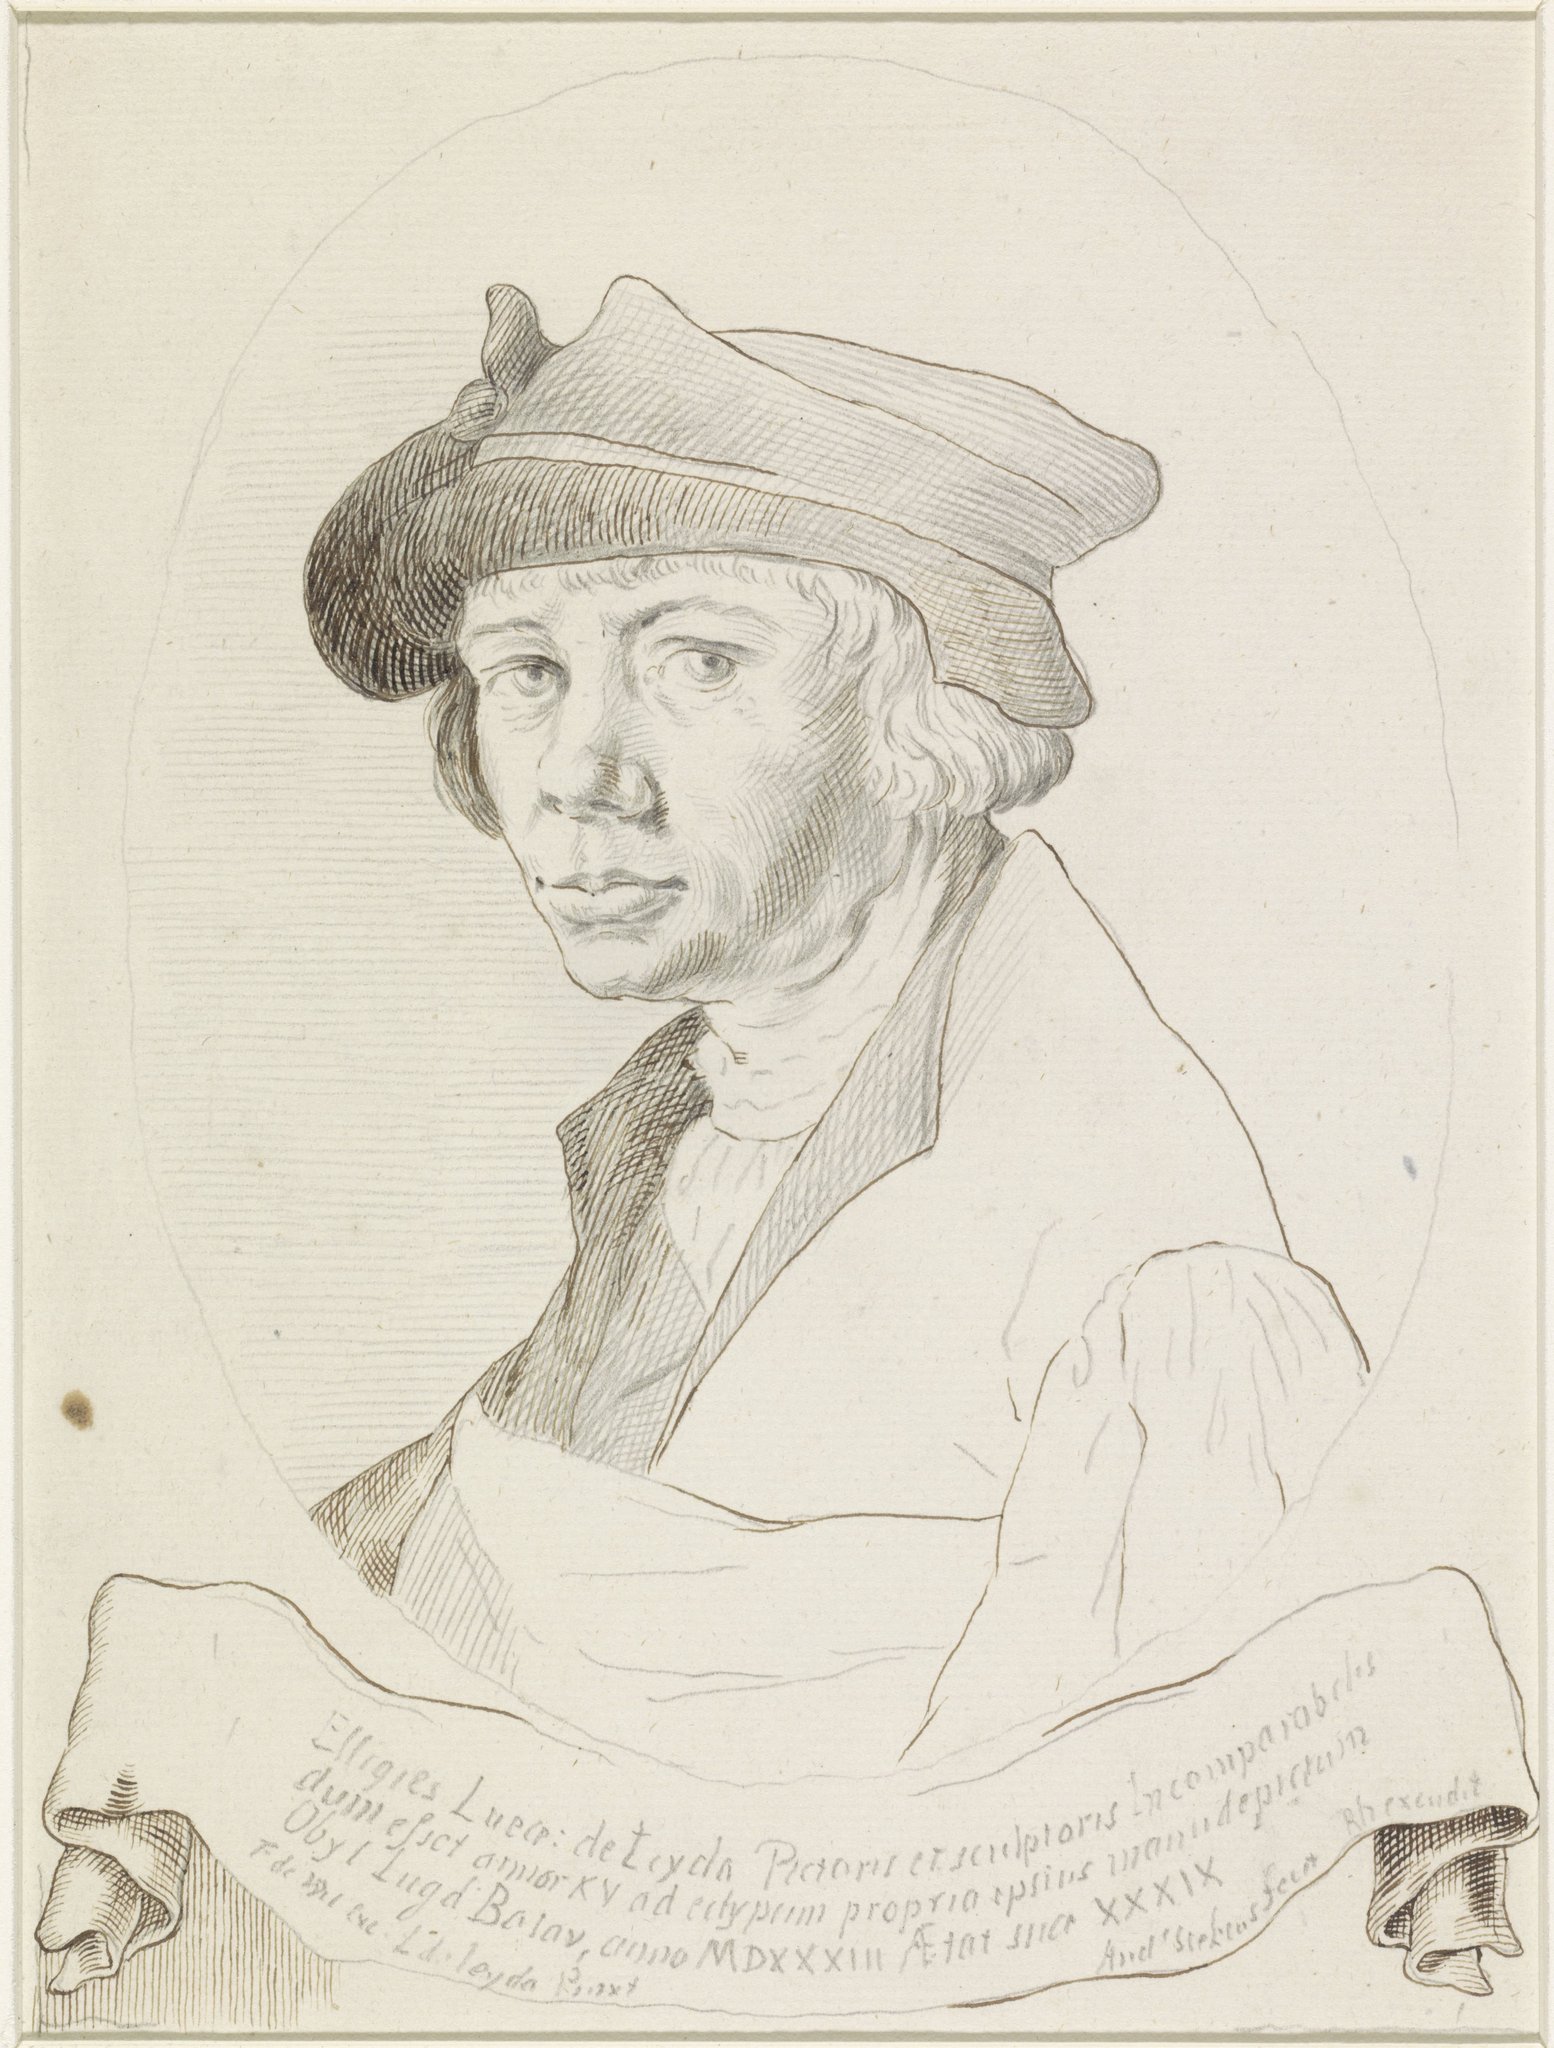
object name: drawing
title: Portret van Lucas van Leyden, in ovaal naar links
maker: Anonymous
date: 1582-1698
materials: ink, paper, pencil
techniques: pen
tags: leiden, painter, draughtsman, lucas van leyden, historical persons, portrait, self-portrait of artist